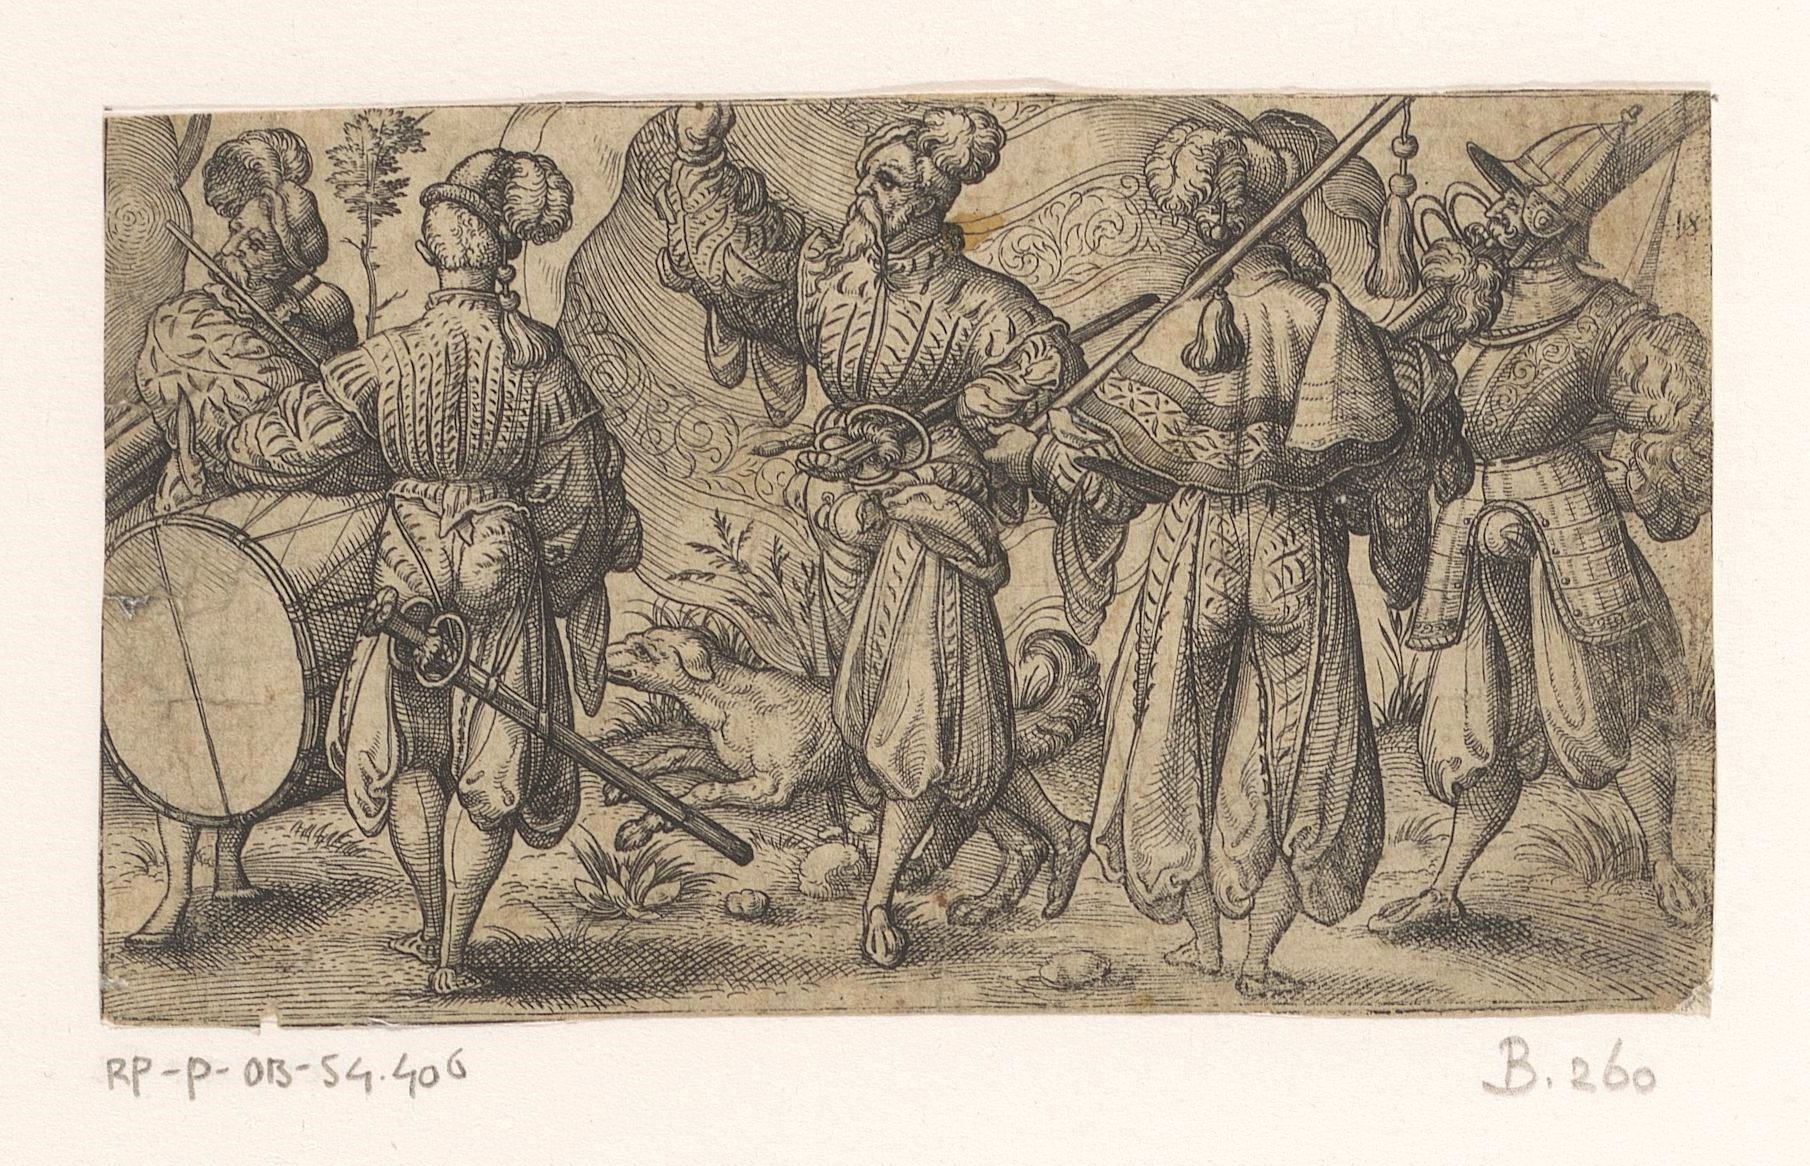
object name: print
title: Vijf landsknechten met banieren en muziekinstrumenten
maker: virgilius solis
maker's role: draughtsman, print maker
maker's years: 1514-1562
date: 1524-1562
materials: paper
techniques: engraving, etching, intaglio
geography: nuremberg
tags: transverse flute - cc - out of doors, (military) standard-bearer, the soldier; the soldier's life, drum (musical instrument) - cc - out of doors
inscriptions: collector's mark: Lugt 2228